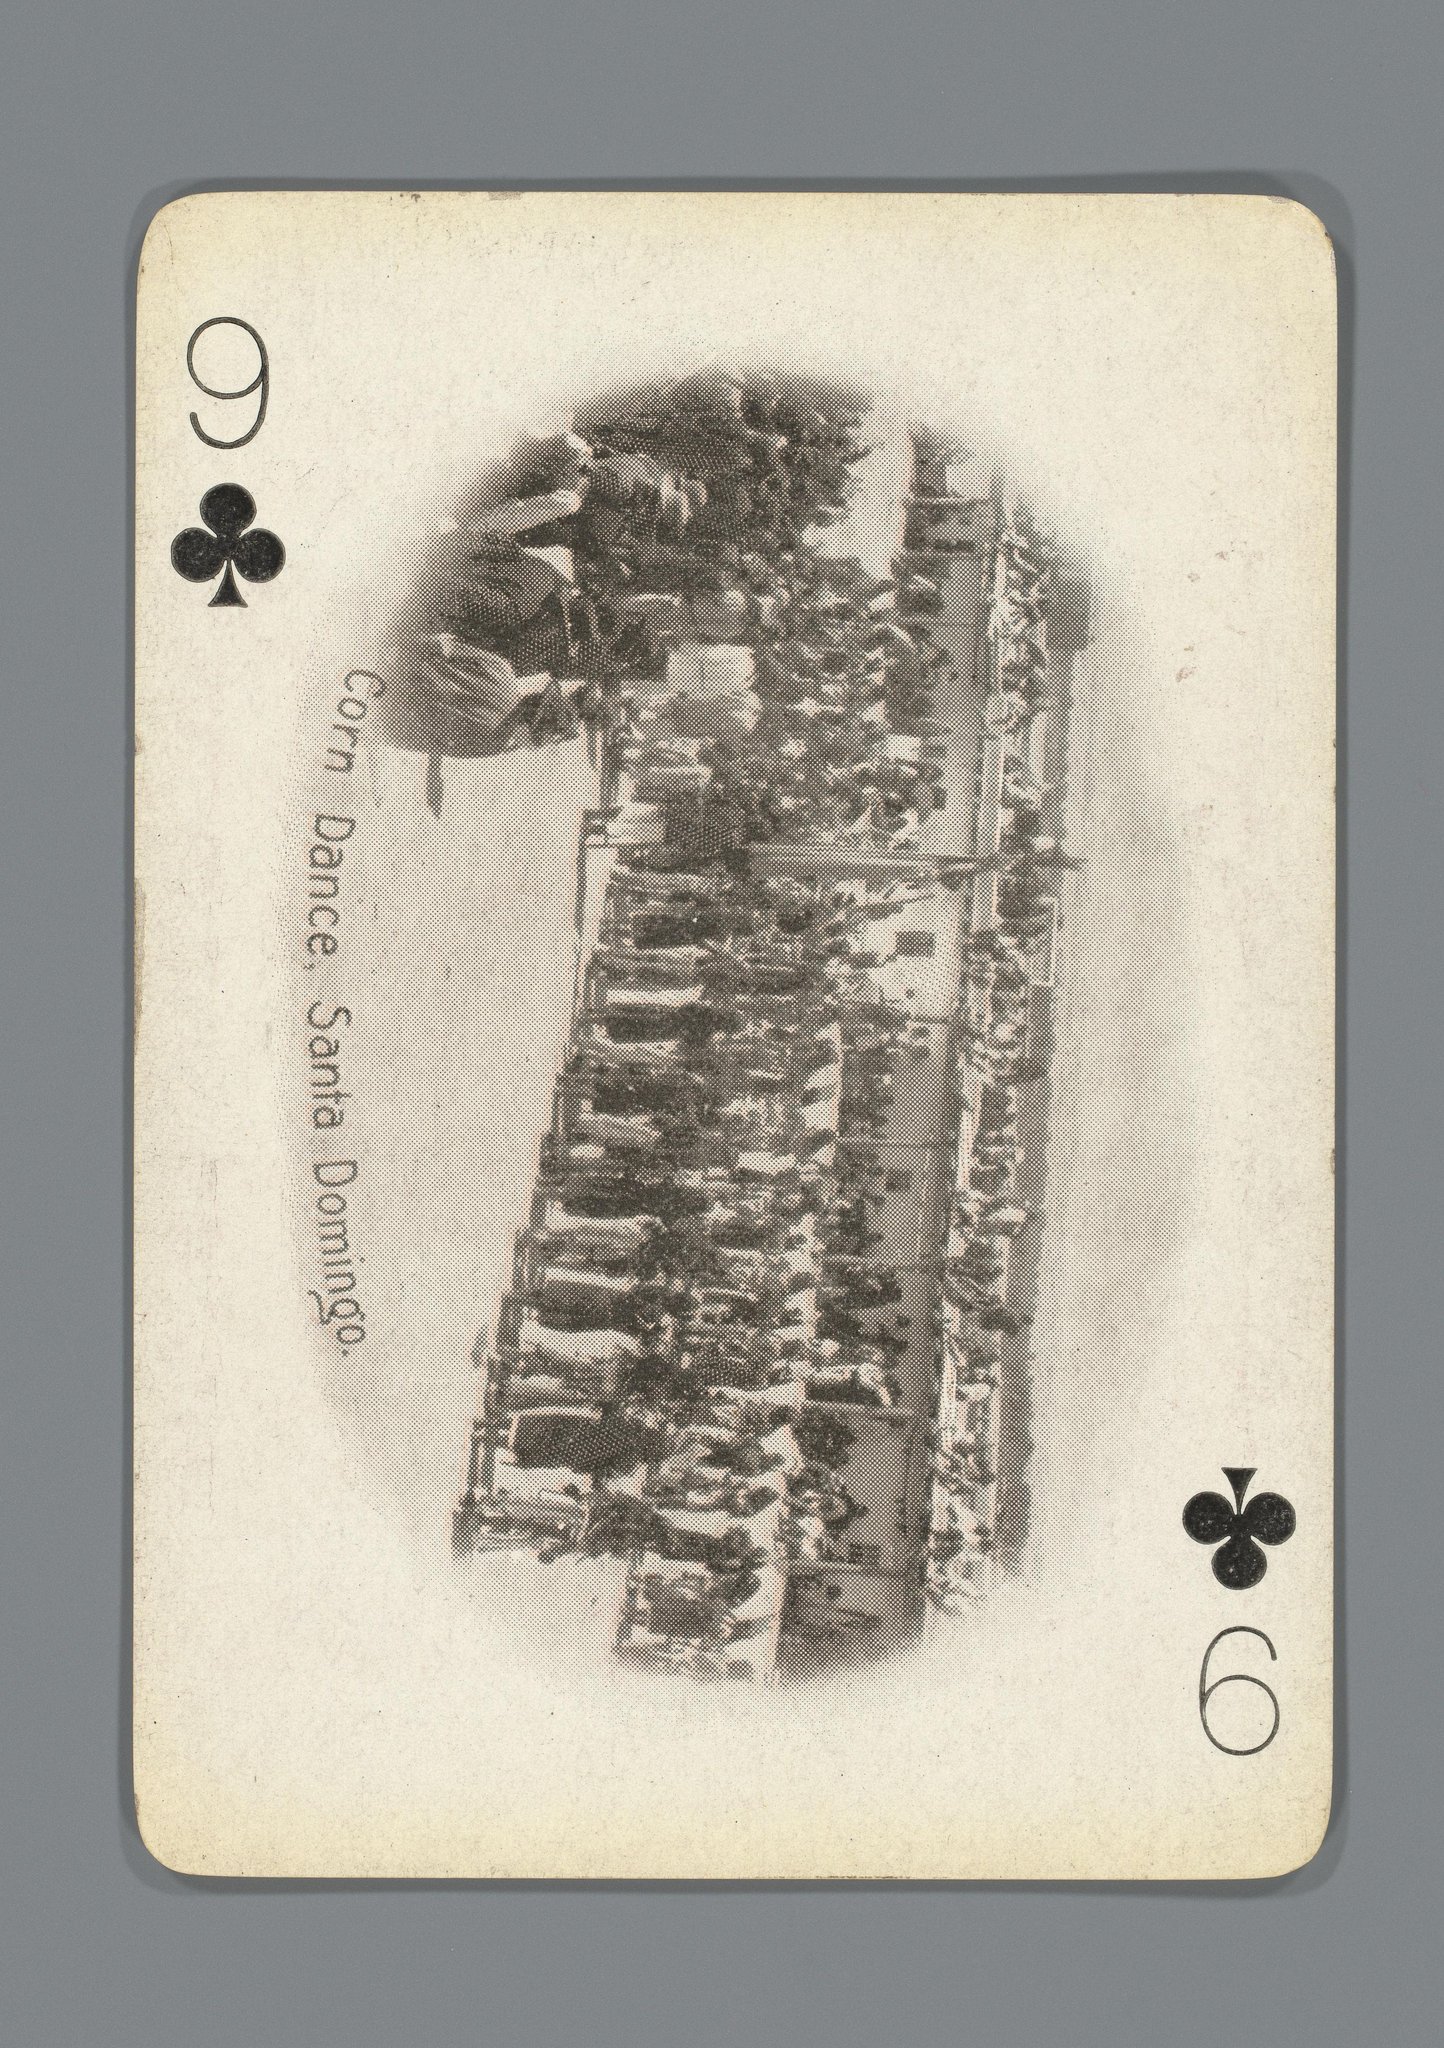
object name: photograph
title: Klaver negen met feest (naamdag) van Santa Domingo, Santa Domingo Pueblo, New Mexico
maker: adam clark vroman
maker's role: fotograaf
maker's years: 1856-1916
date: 1900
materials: paper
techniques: autotype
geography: united states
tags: new mexico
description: Speelkaart uit doosje met 53 speelkaarten met afbeeldingen in autotypie van Native Americans. De inhoud bevat een complete set speelkaarten inclusief joker.